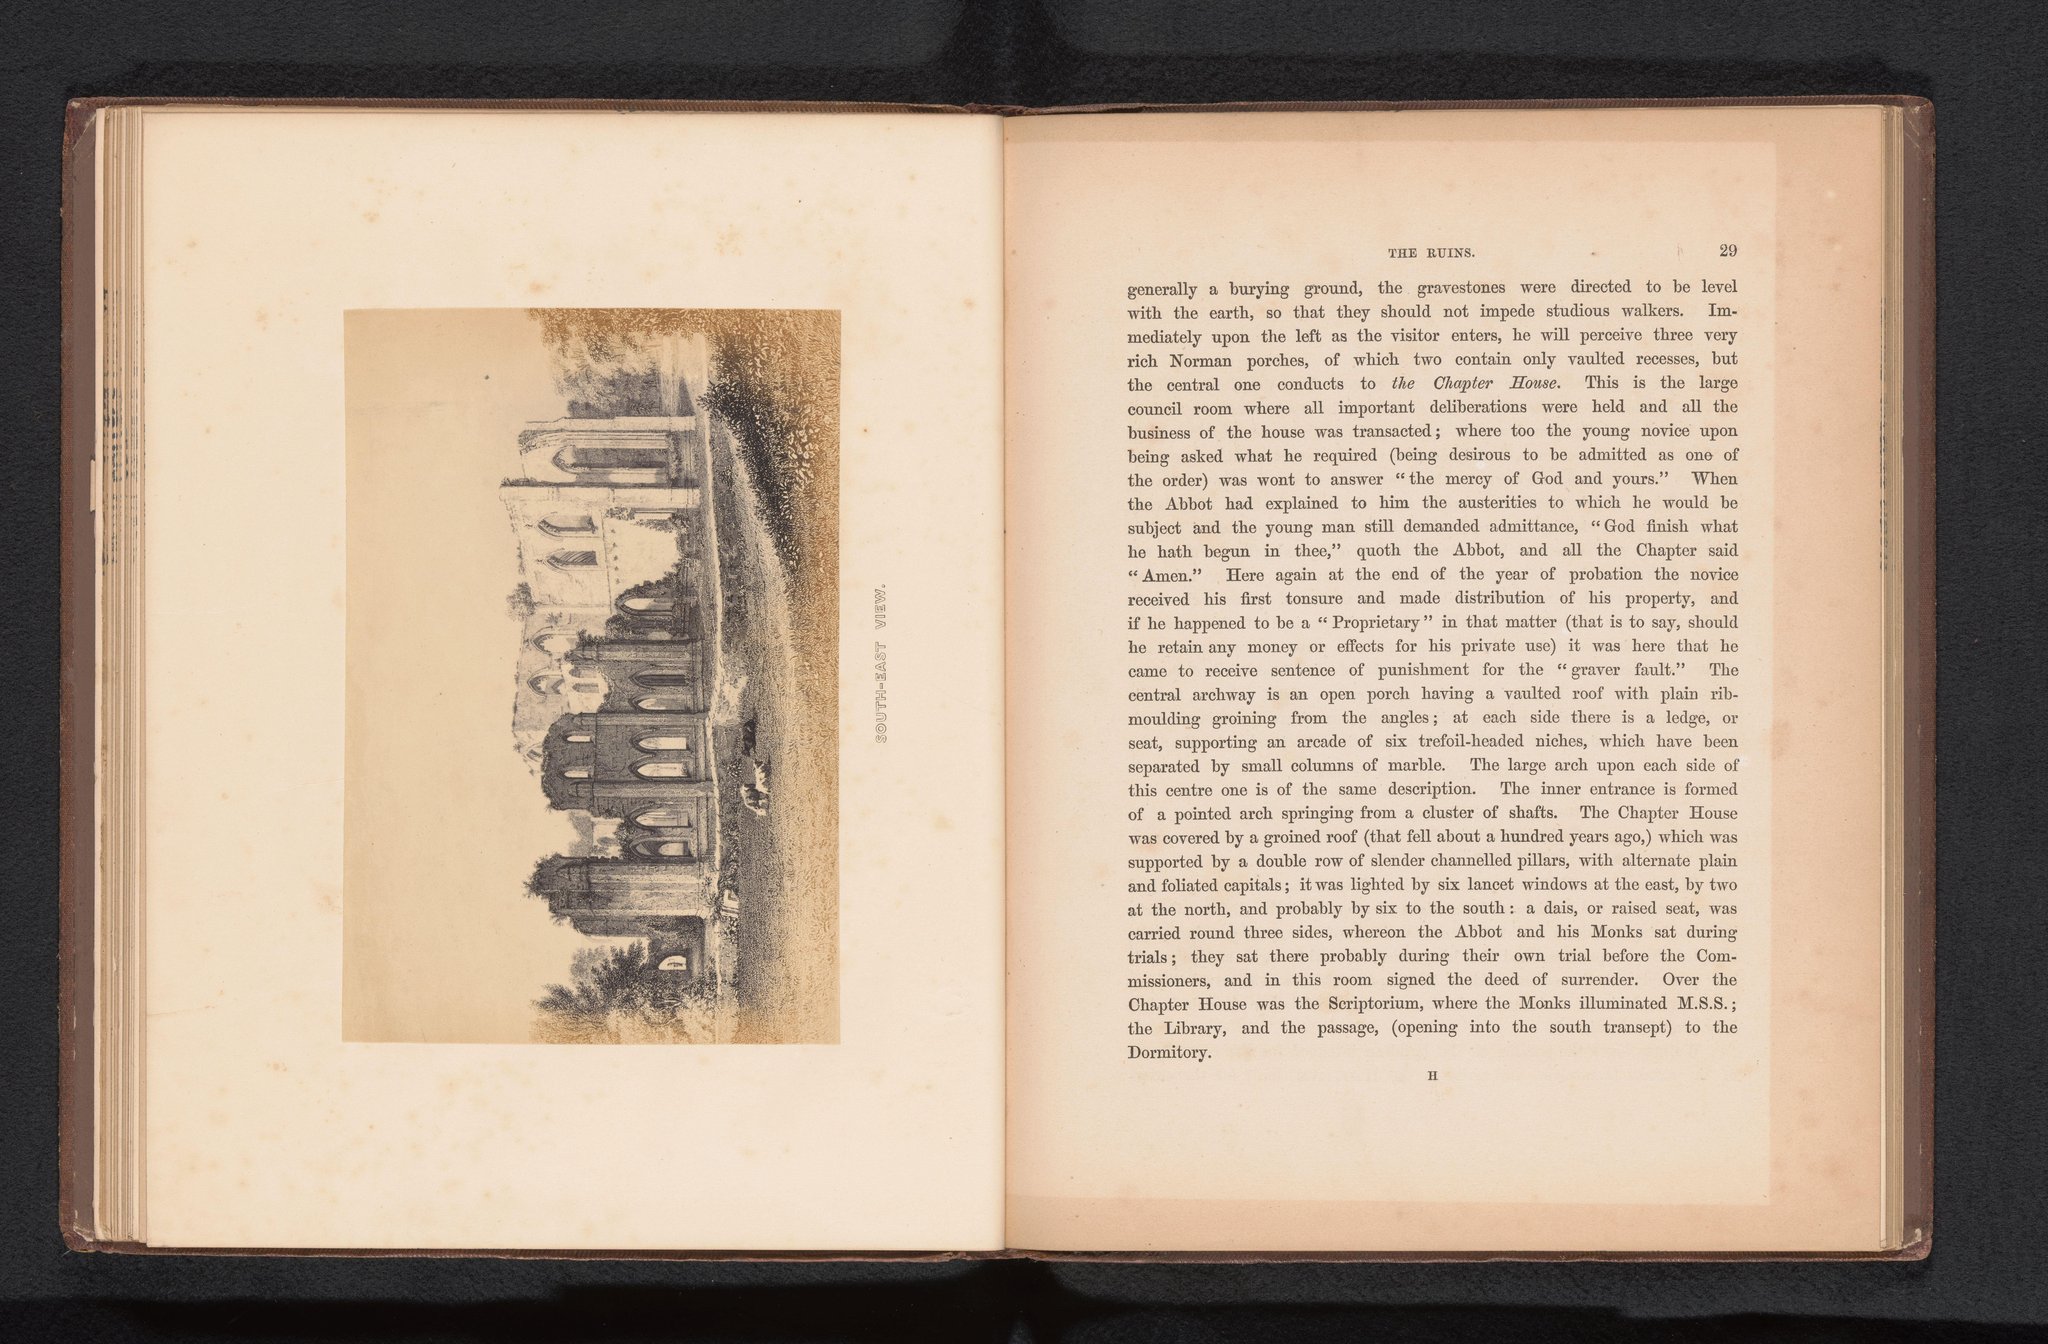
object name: photograph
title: South-east view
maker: Anonymous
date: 1859-1864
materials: photographic support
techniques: albumen print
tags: ruin of church, monastery, etc.